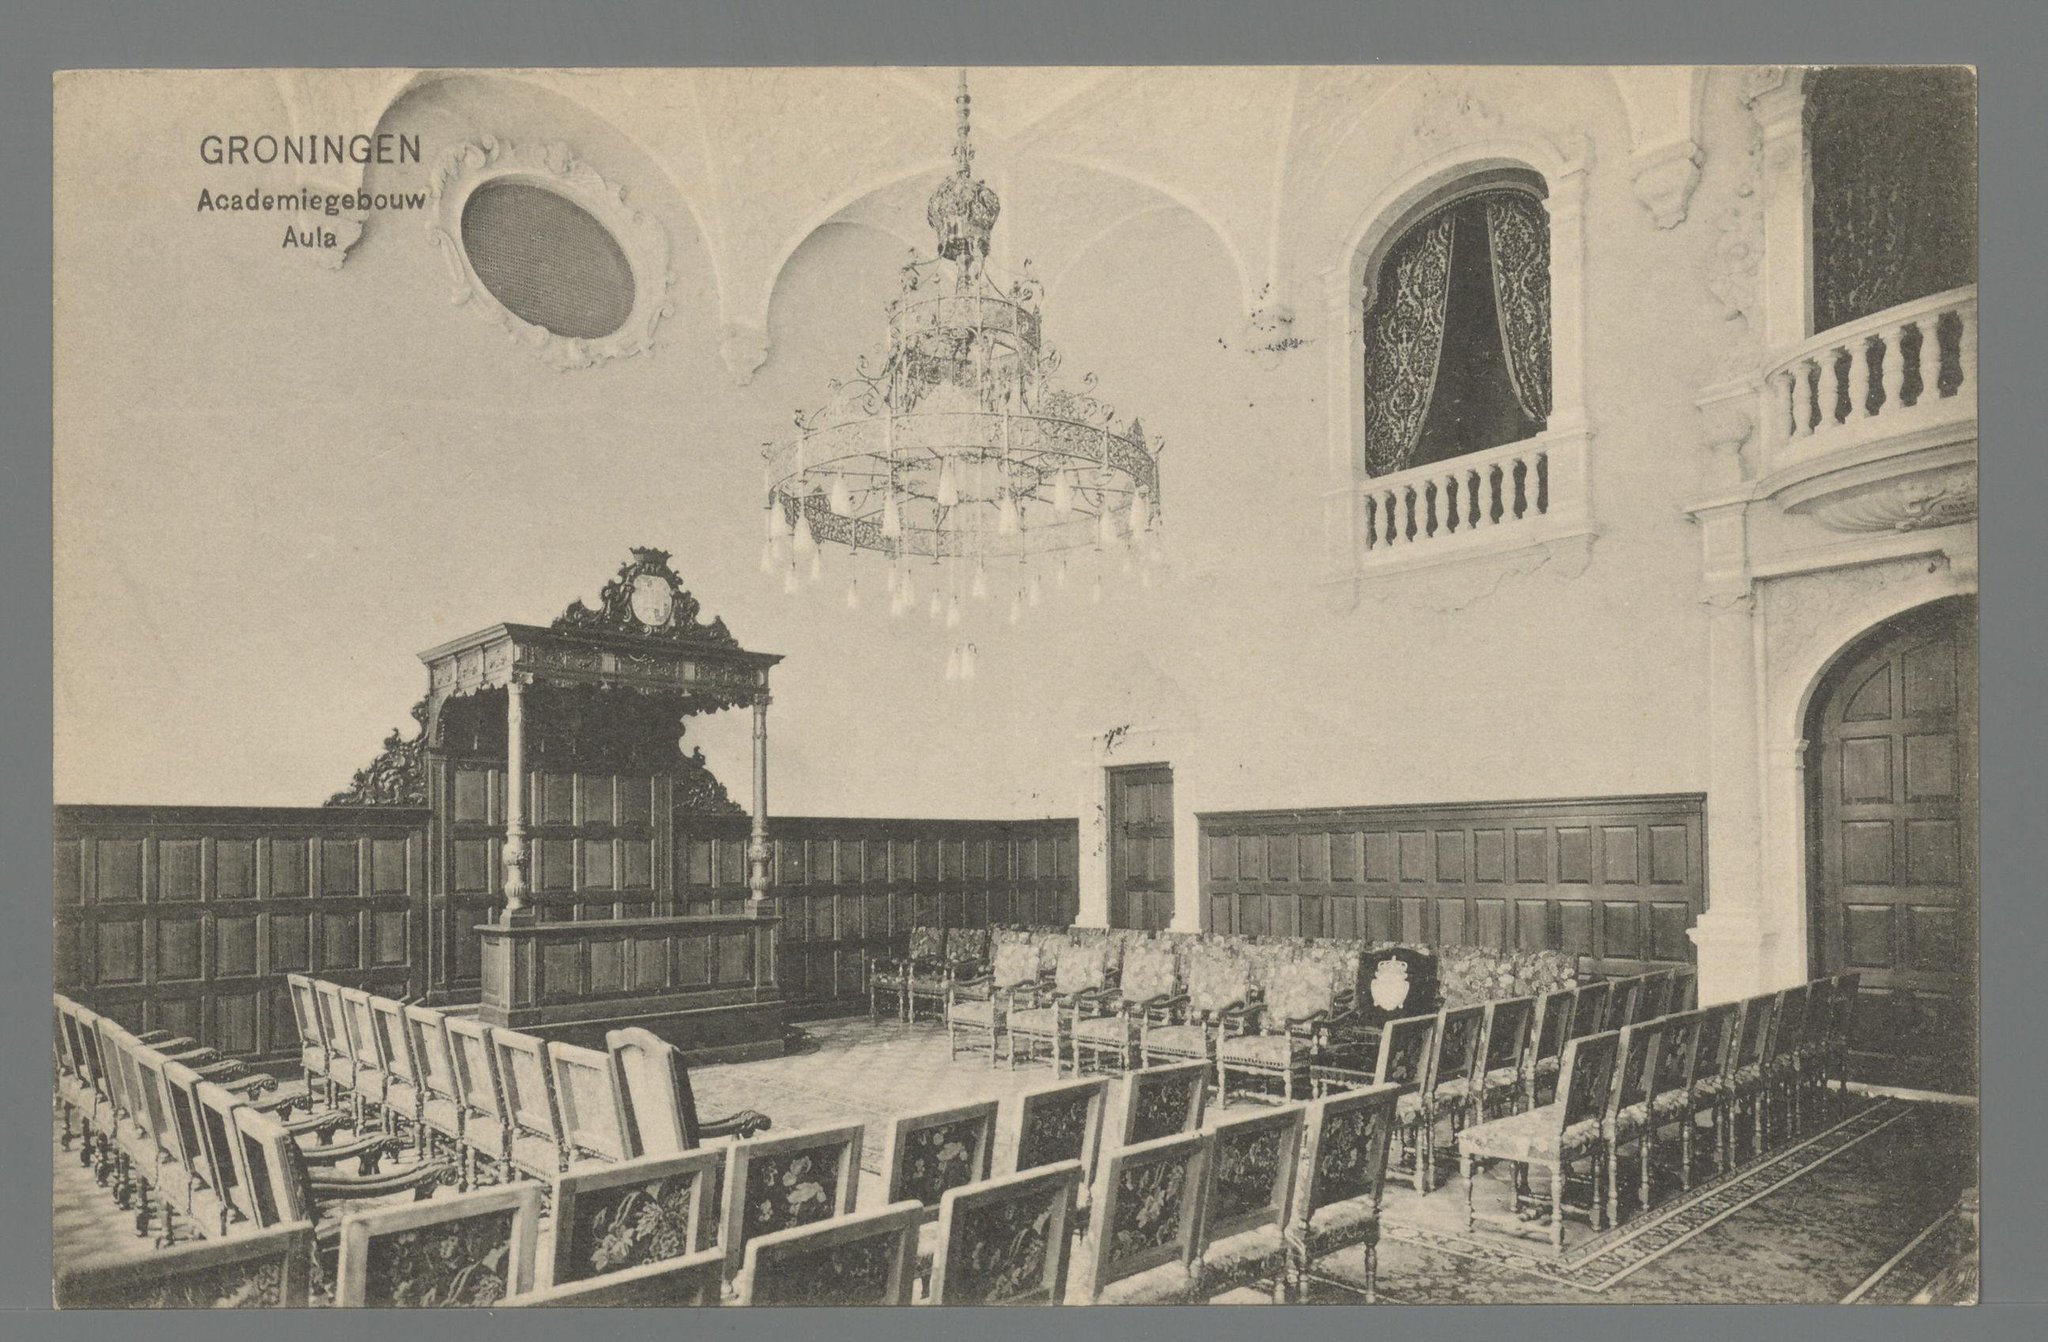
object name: photomechanical print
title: Groningen. Academiegebouw. Aula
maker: Anonymous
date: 1909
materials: cardboard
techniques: photograph, writing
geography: groningen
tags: university building, college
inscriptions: postage stamp